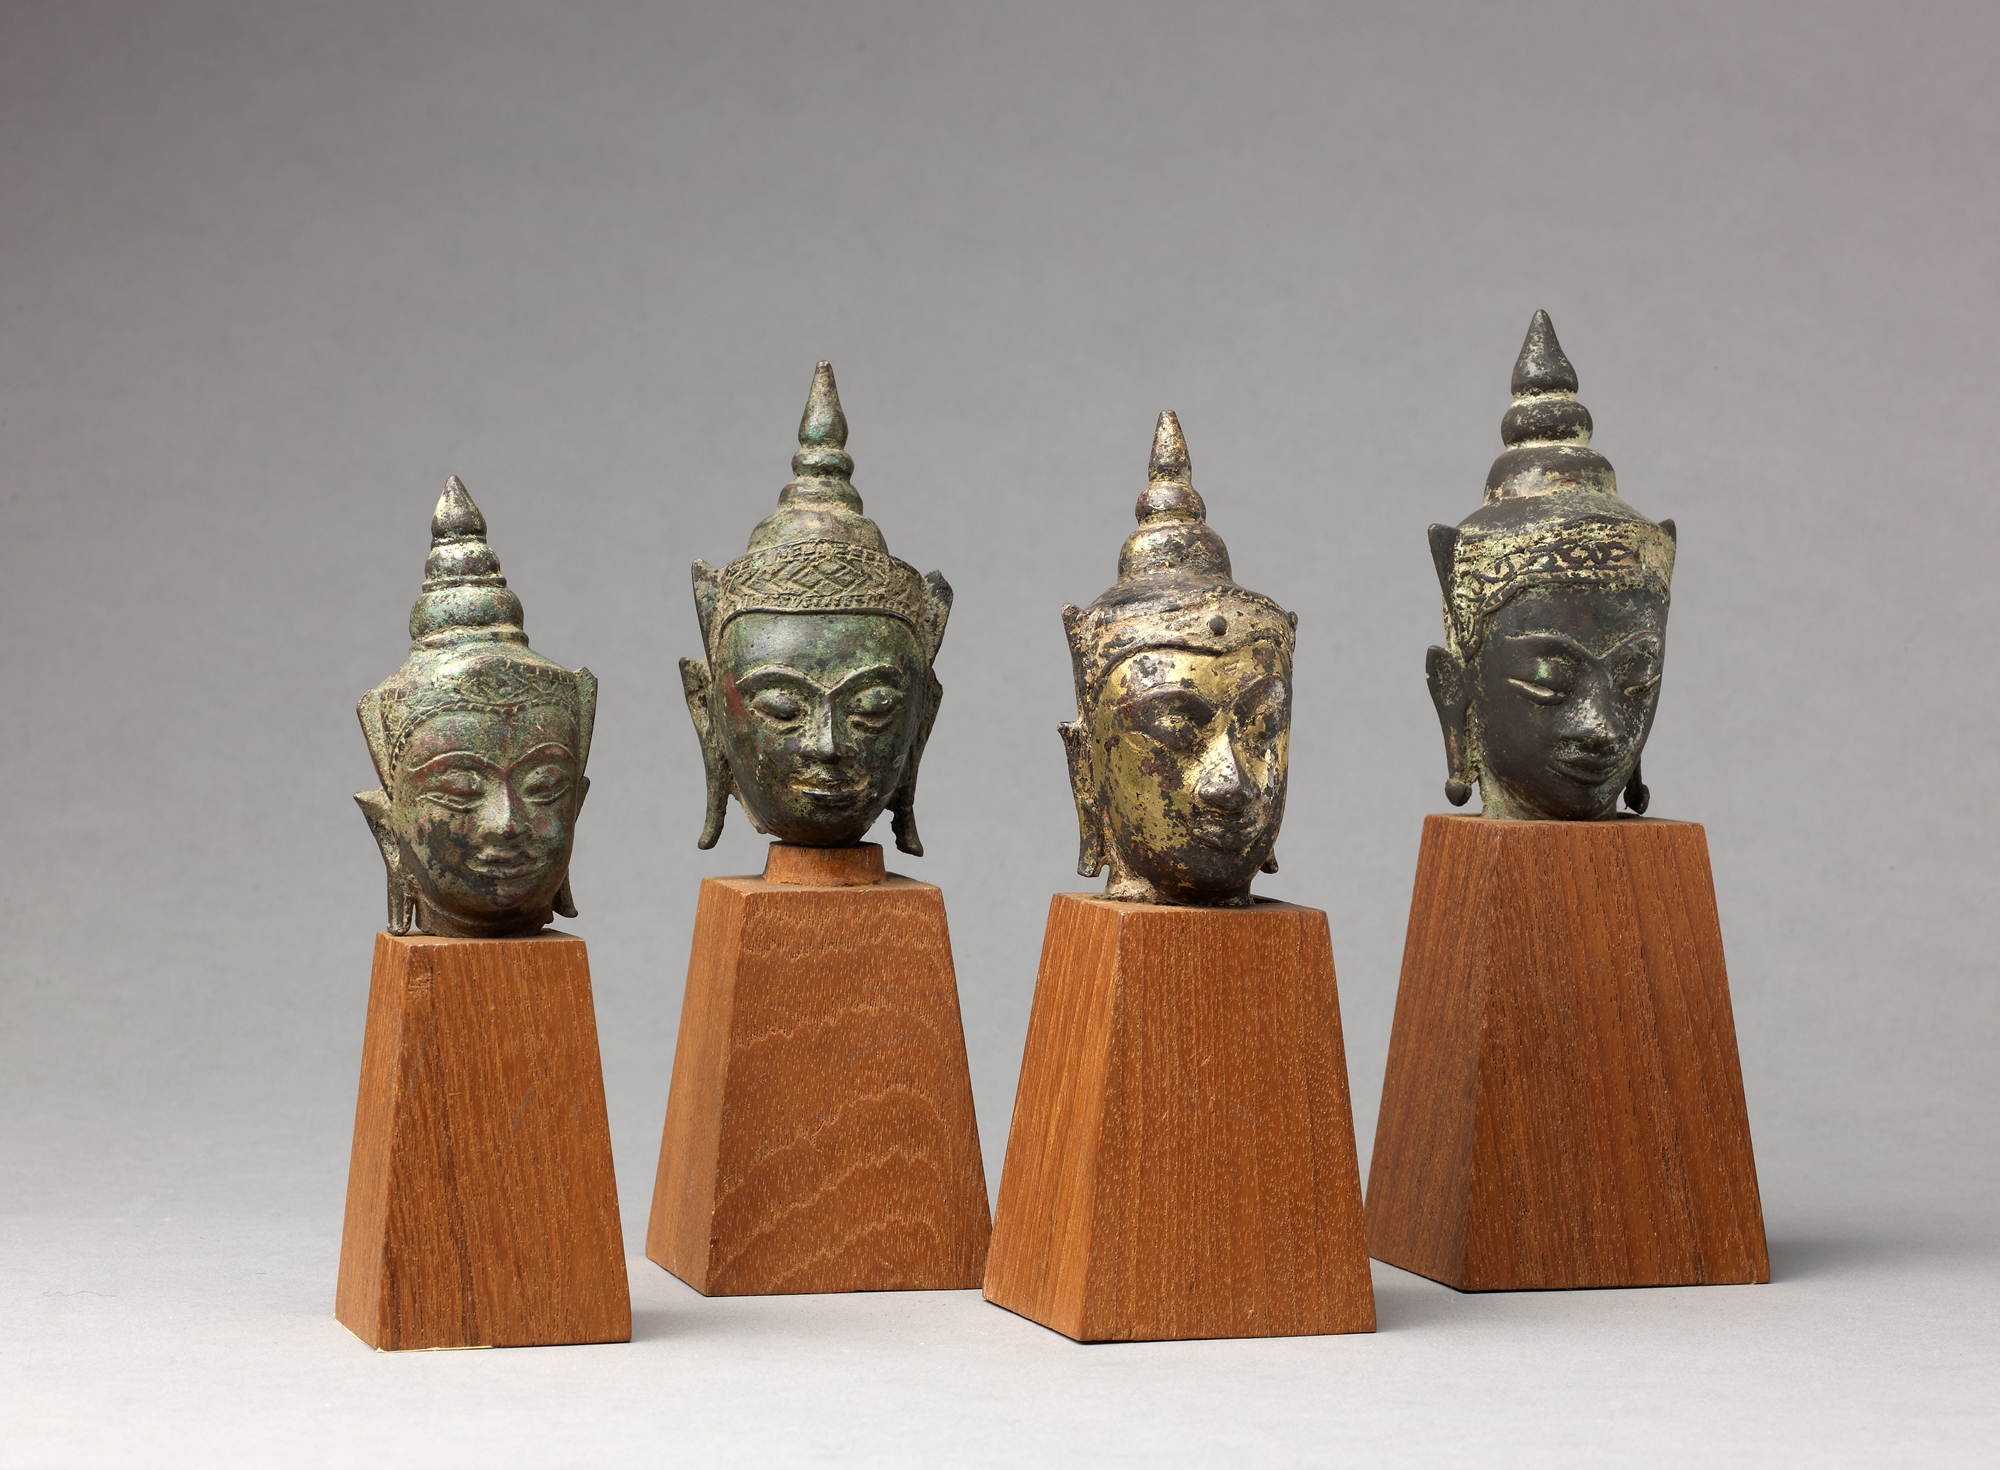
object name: sculpture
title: Head of the Buddha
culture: thai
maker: thai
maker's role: artist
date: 1767-1900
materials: copper alloy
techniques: gilding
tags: heads,buddha